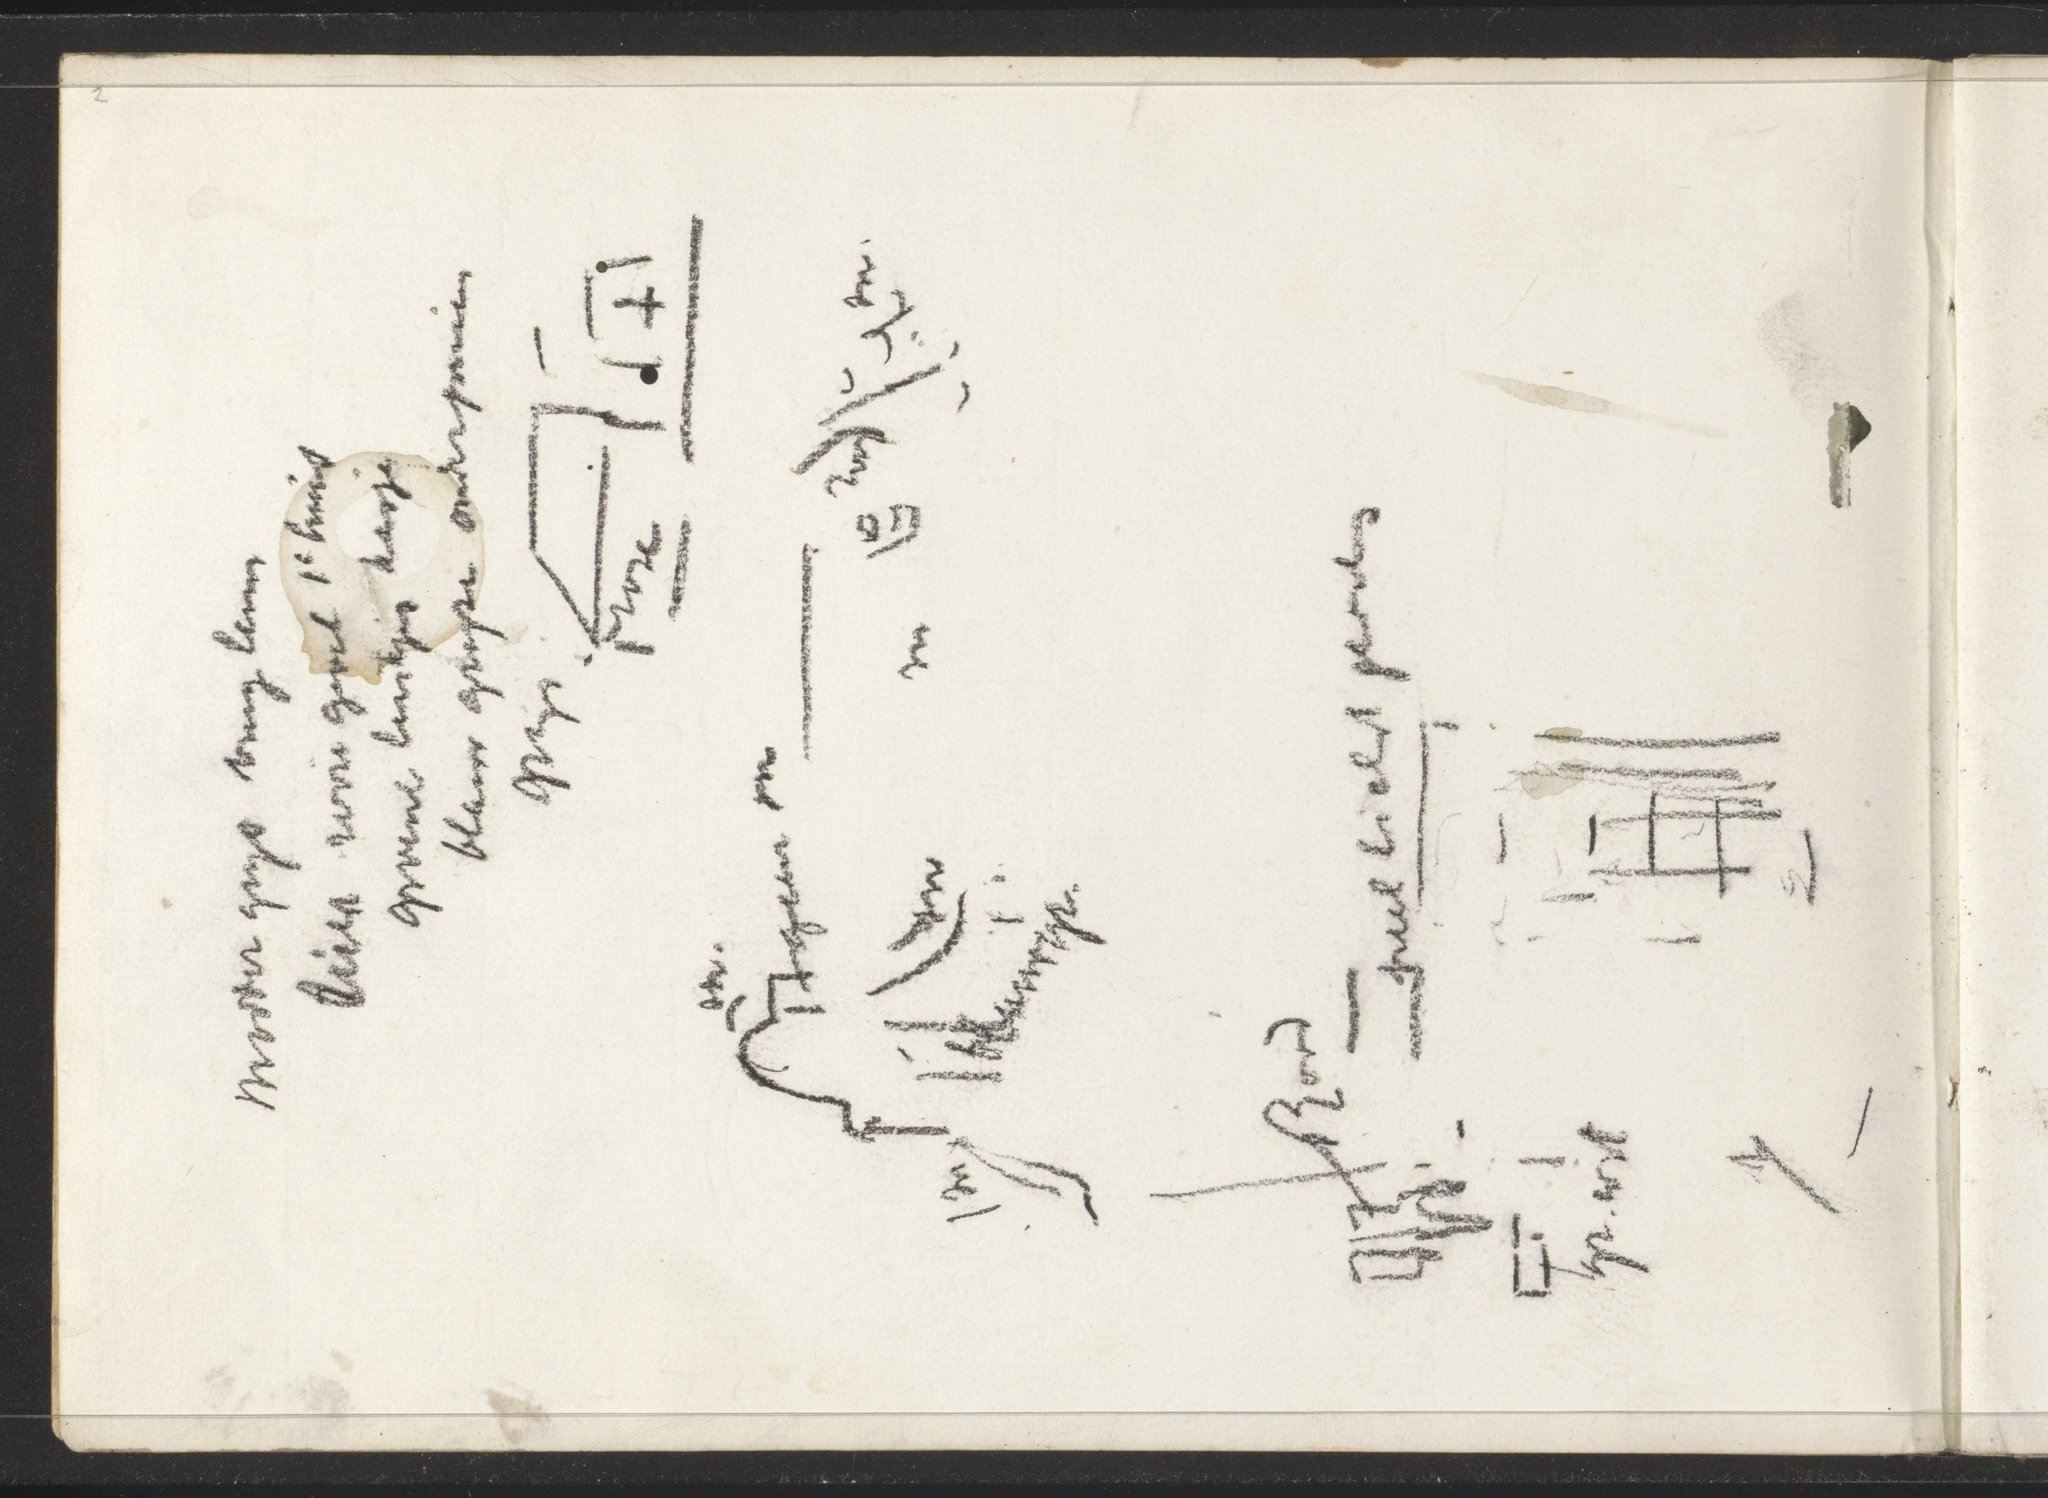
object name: sketchbook leaf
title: Architectuurstudies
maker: willem witsen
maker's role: draughtsman, painter, print maker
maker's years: 1860-1923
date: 1897-1898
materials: chalk, paper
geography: amsterdam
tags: architectural detail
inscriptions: kleurnotitie, handgeschreven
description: Pagina 2 uit een schetsboek met 12 bladen.